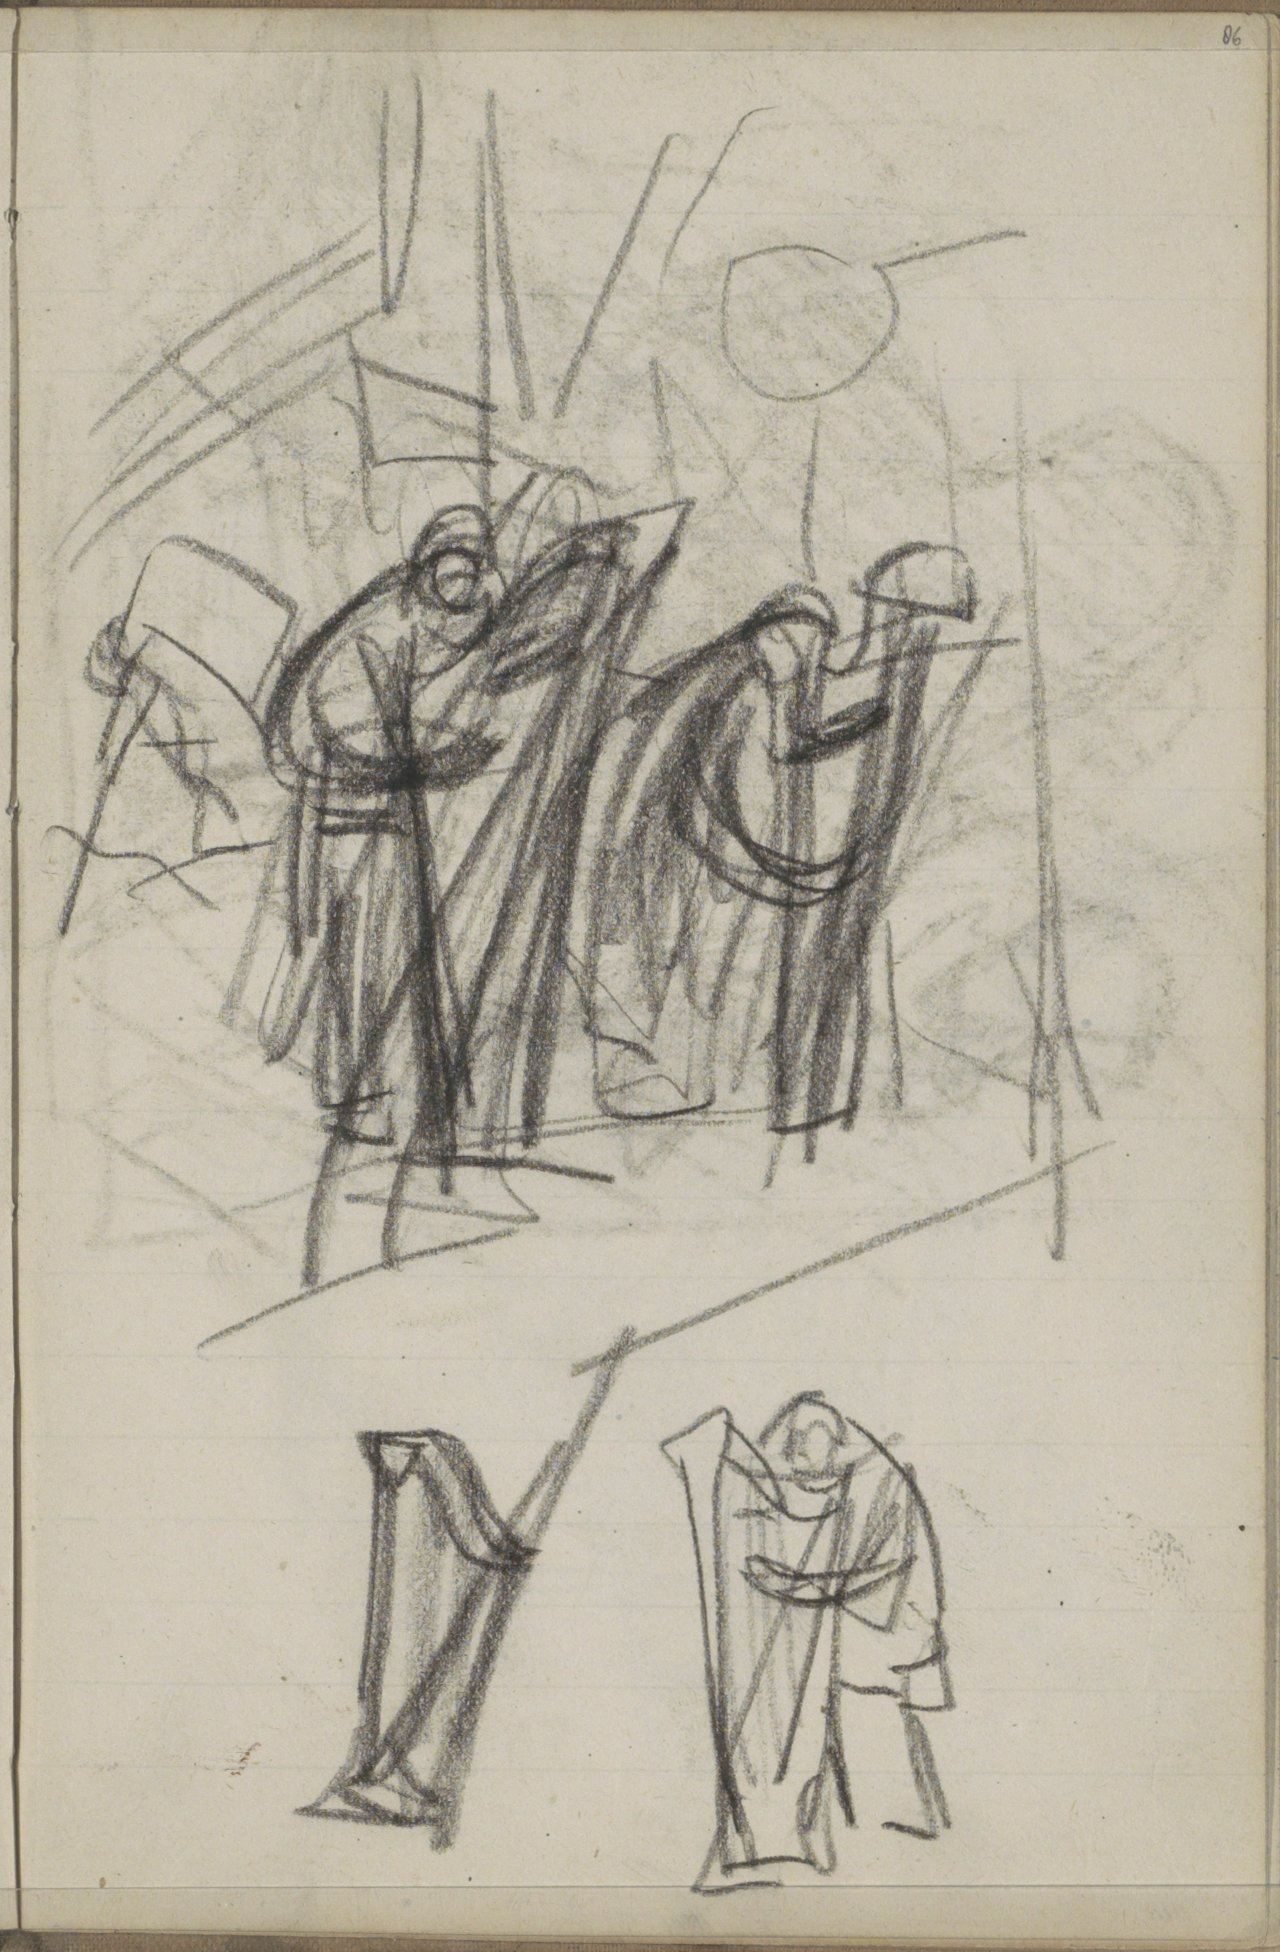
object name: sketchbook leaf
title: Harpspelers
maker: marius bauer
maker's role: draughtsman, print maker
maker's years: 1867-1932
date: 1888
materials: chalk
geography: istanbul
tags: musician, harp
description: Pagina 86 uit een schetsboek met 56 bladen.